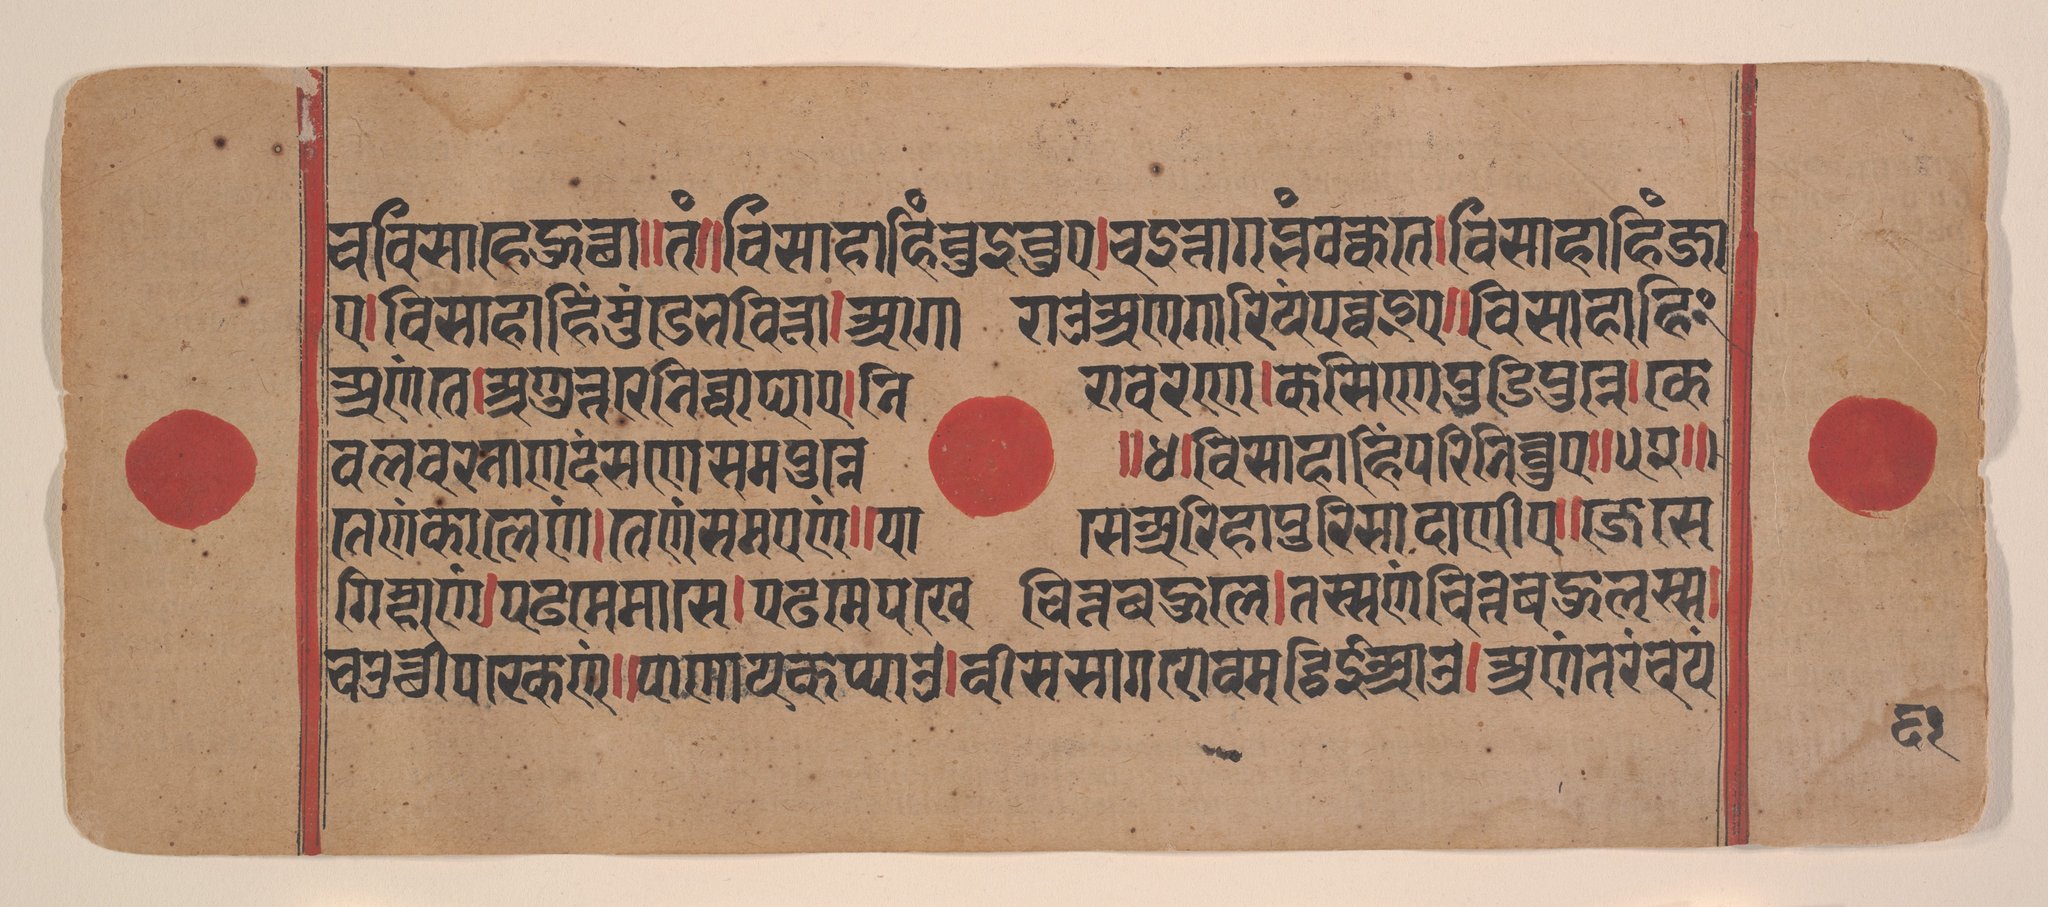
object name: folio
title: Page from a Dispersed Kalpa Sutra (Jain Book of Rituals)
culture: indian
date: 1401-1500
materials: gold, ink, paper, watercolor